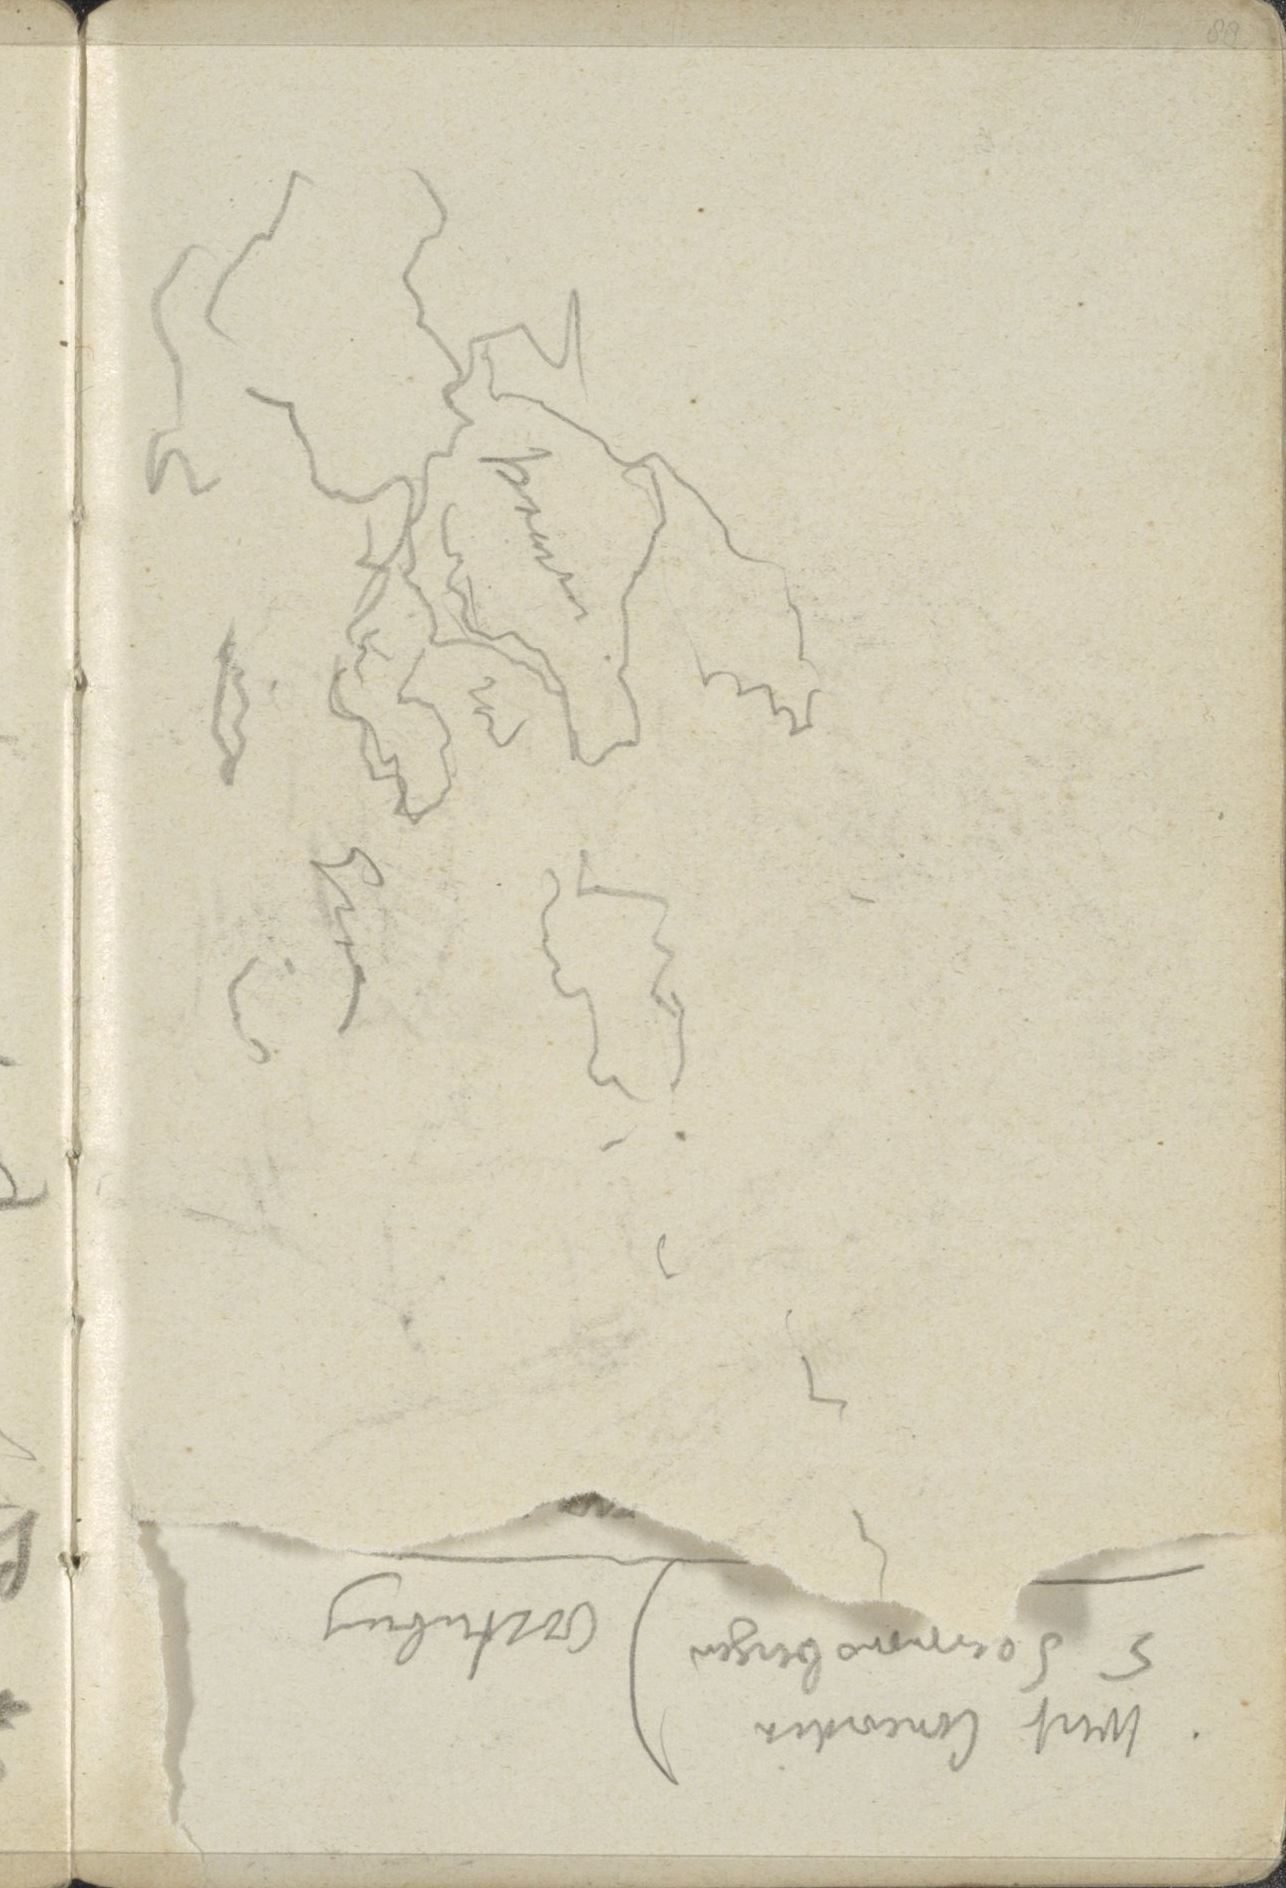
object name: sketchbook leaf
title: Wolken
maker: george hendrik breitner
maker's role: draughtsman, painter, print maker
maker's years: 1857-1923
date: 1910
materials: paper, pencil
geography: amsterdam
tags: clouds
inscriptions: kleurnotitie, handgeschreven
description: Pagina 88 uit een schetsboek met 45 bladen.